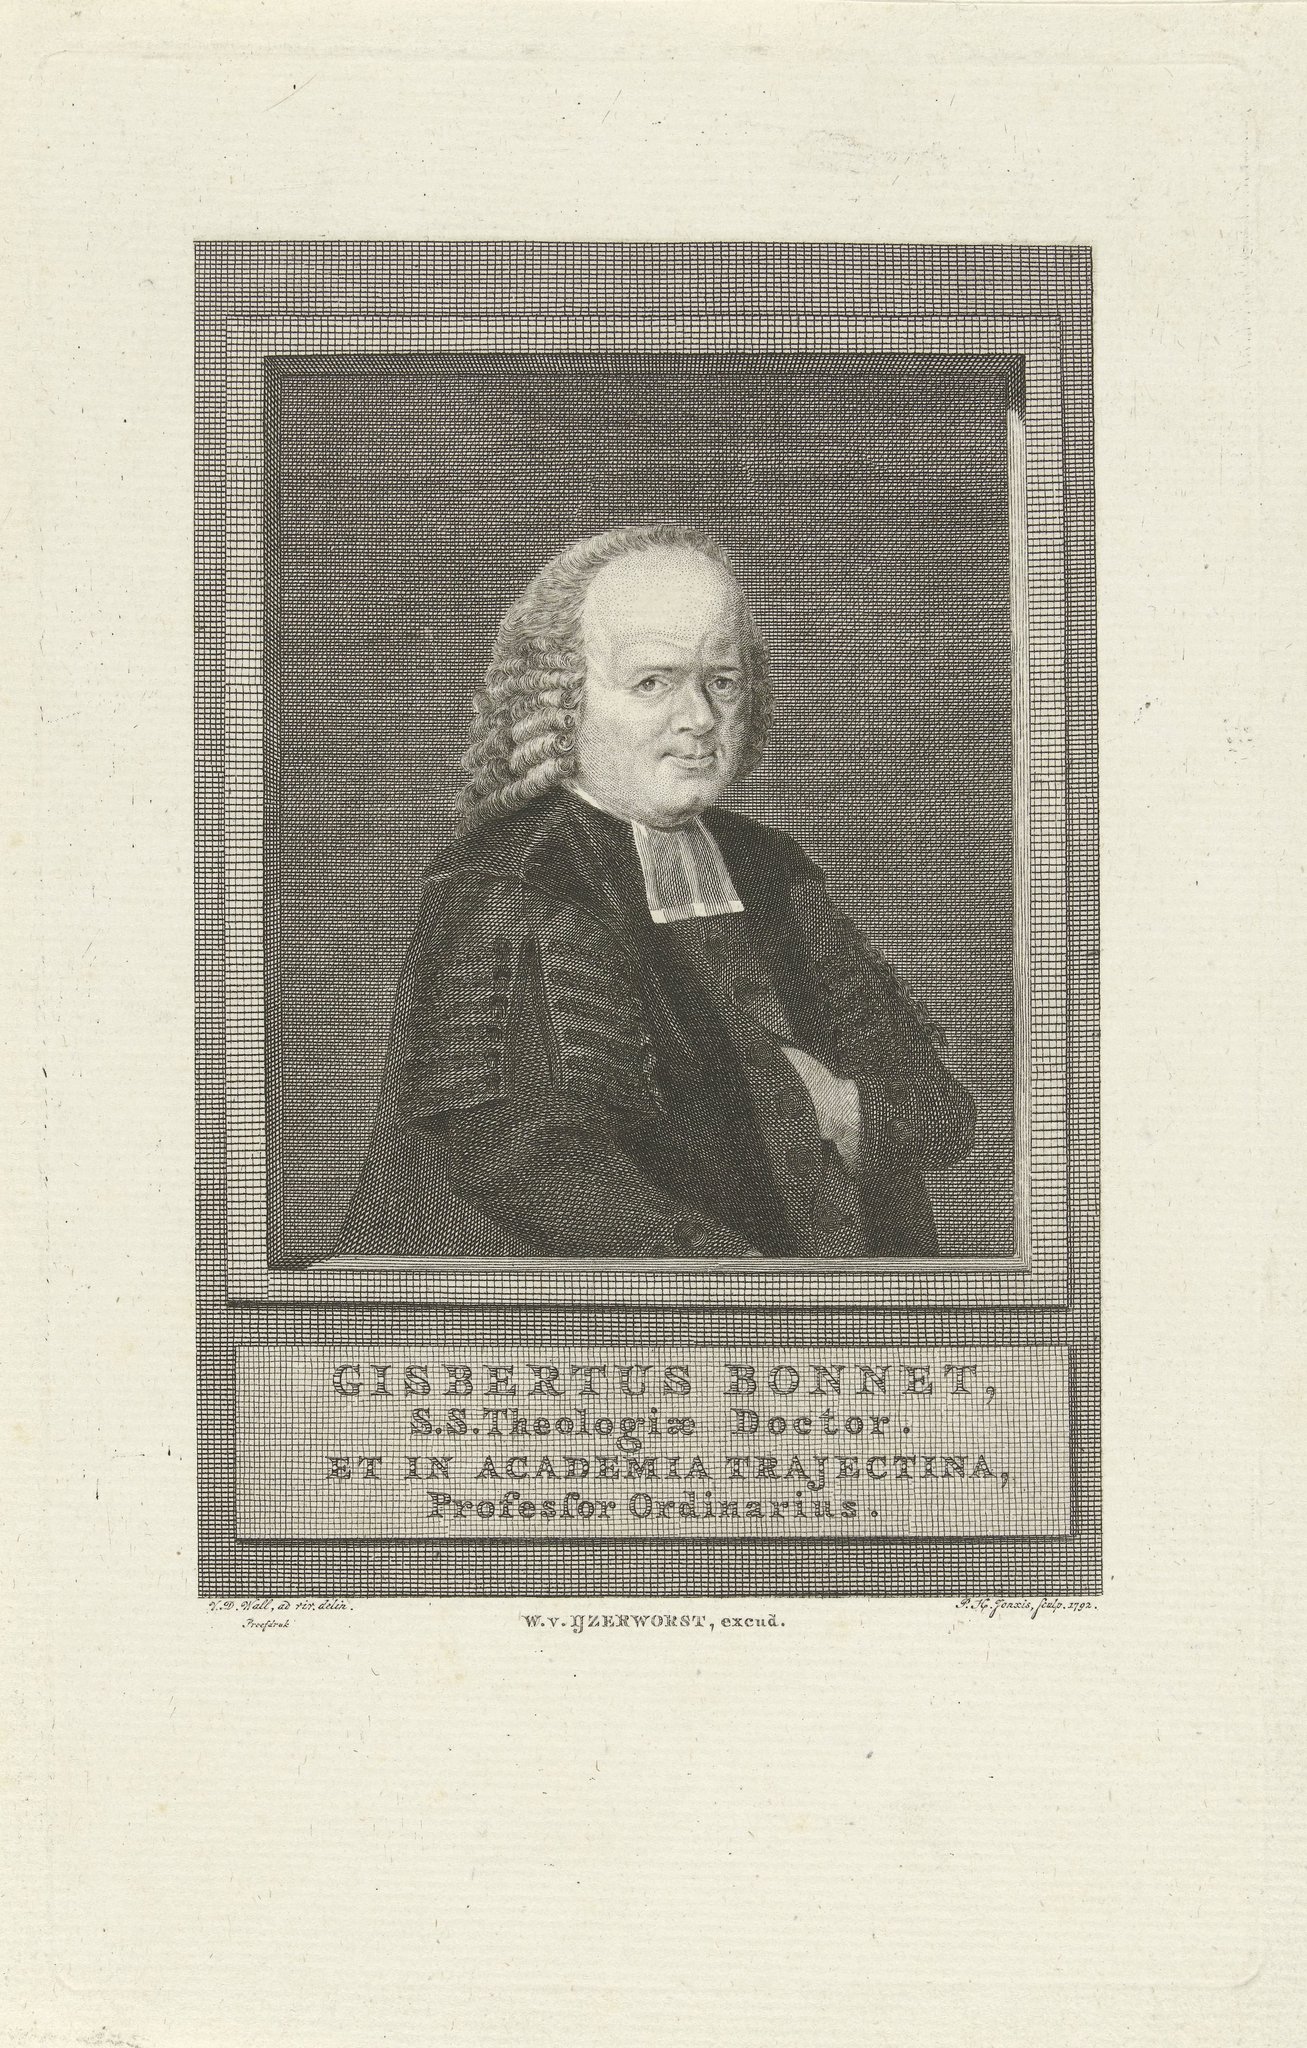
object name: print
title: Portret van Gisbertus Bonnet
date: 1792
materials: paper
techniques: etching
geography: utrecht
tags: utrecht, gisbertus bonnet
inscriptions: collector's mark: Lugt 2228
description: Portret van de theoloog Gisbertus Bonnet, ten halven lijve. Hij heeft zijn linkerhand in zijn jas gestoken. Het portret is gevat in een rechthoekige omlijsting met in een kader de naam en functie van de geportretteerde in het Nederlands.